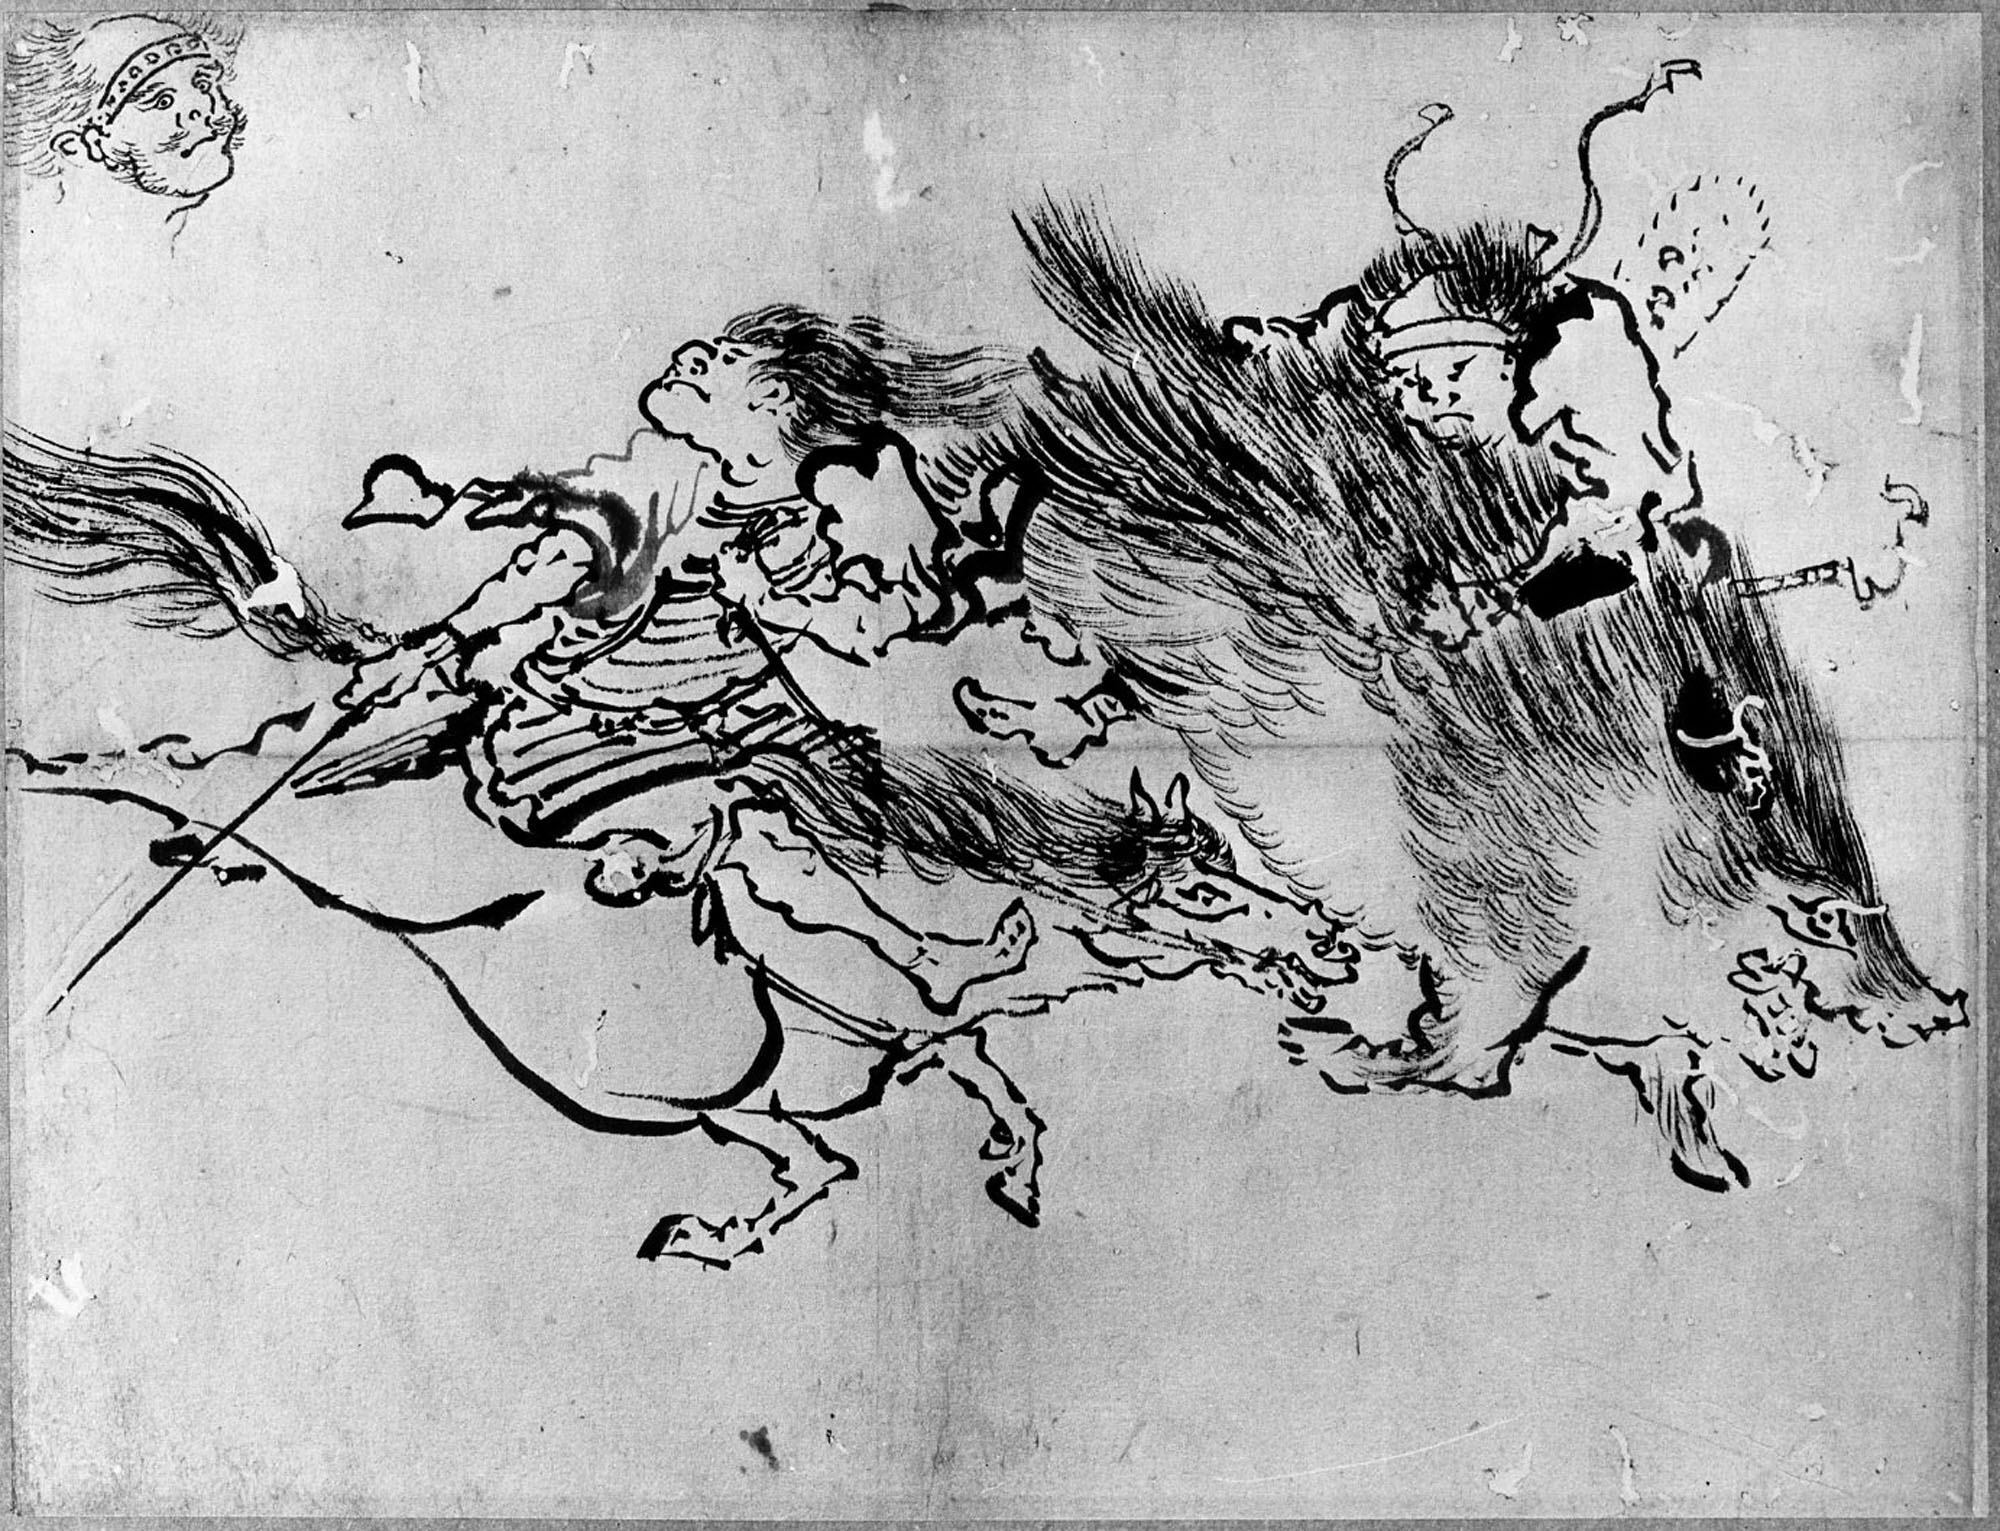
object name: painting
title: Two Figures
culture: japanese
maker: katsushika hokusai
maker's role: artist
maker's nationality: japanese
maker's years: 1760-1849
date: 1801-1900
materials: ink, paper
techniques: drawing, painting, wash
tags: men,boars,horses